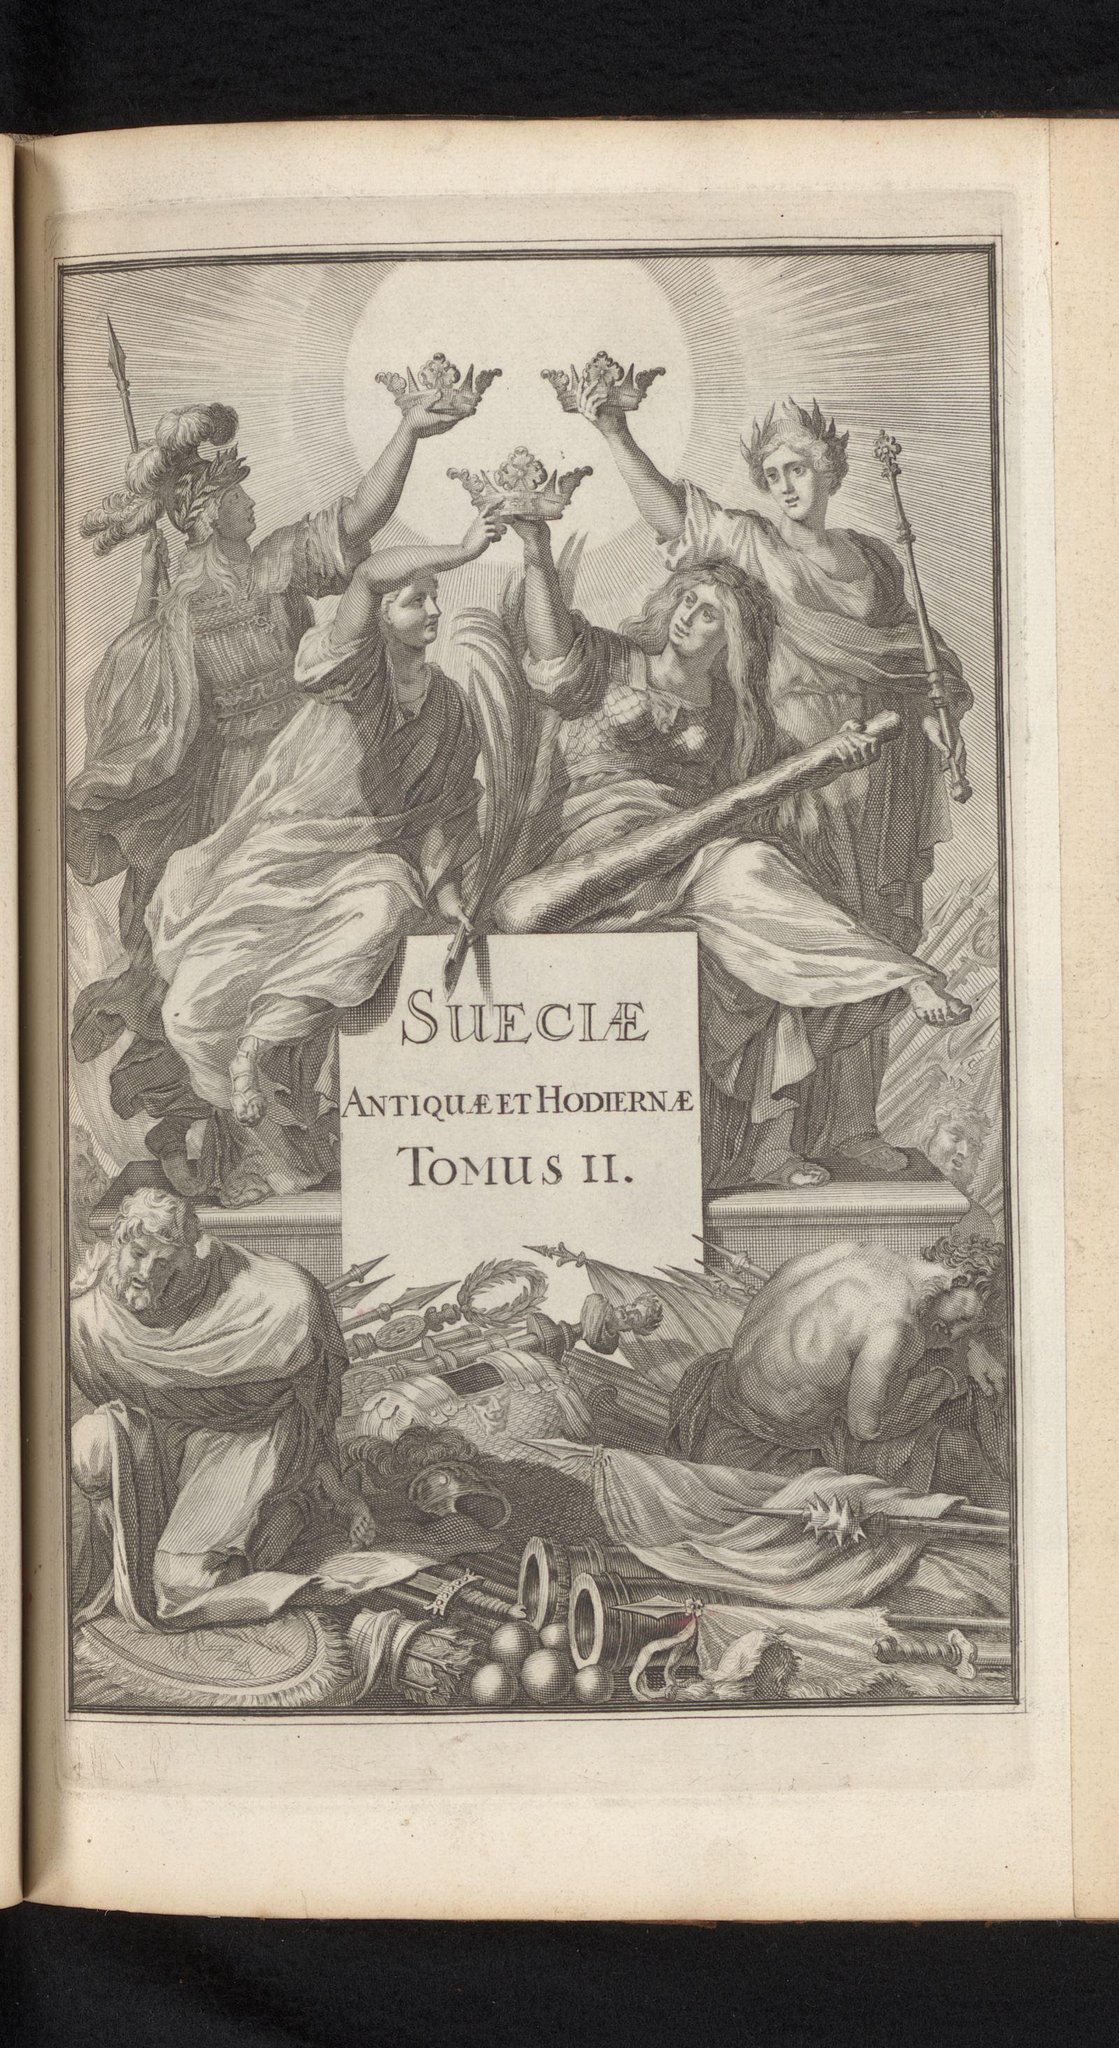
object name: album leaf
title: Titelprent met vier personificaties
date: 1698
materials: paper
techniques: engraving, etching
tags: title-page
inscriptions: collector's mark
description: Allegorische titelprent voor het tweede deel van de reeks getiteld: Suecia antiqua et hodierna. Op een sokkel houden vier vrouwelijke personificaties de drie kronen van het wapen van Zweden omhoog. De vier vrouwen hebben een speer, palmtak, knots en scepter in hun handen. Onderaan twee mannen, hun handen gebonden, tussen de wapens. De prent maakt deel uit van een album.